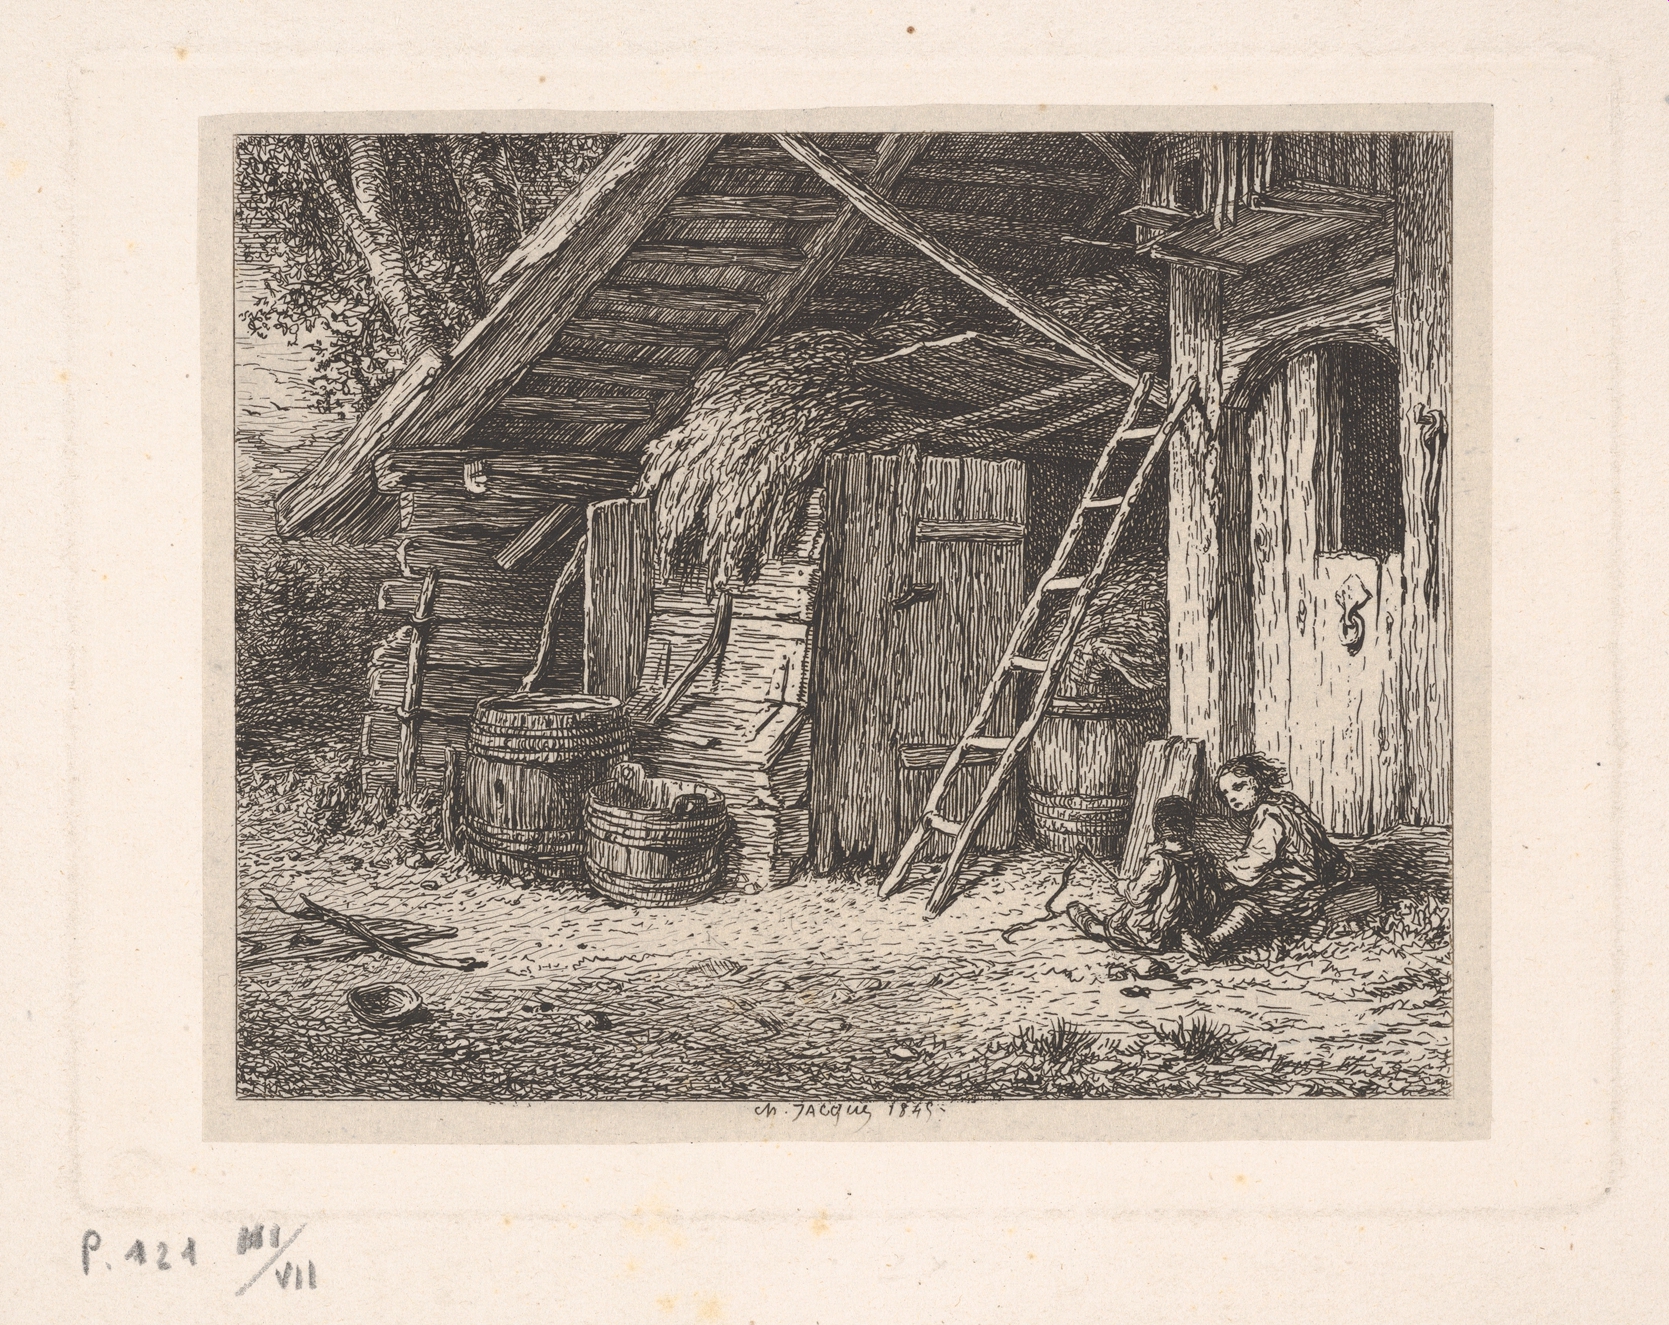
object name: print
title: Coin de Ferme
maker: charles émile jacque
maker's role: artist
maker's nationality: french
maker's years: 1813-1894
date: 1849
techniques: printmaking, etching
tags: human figures,farms,ladders